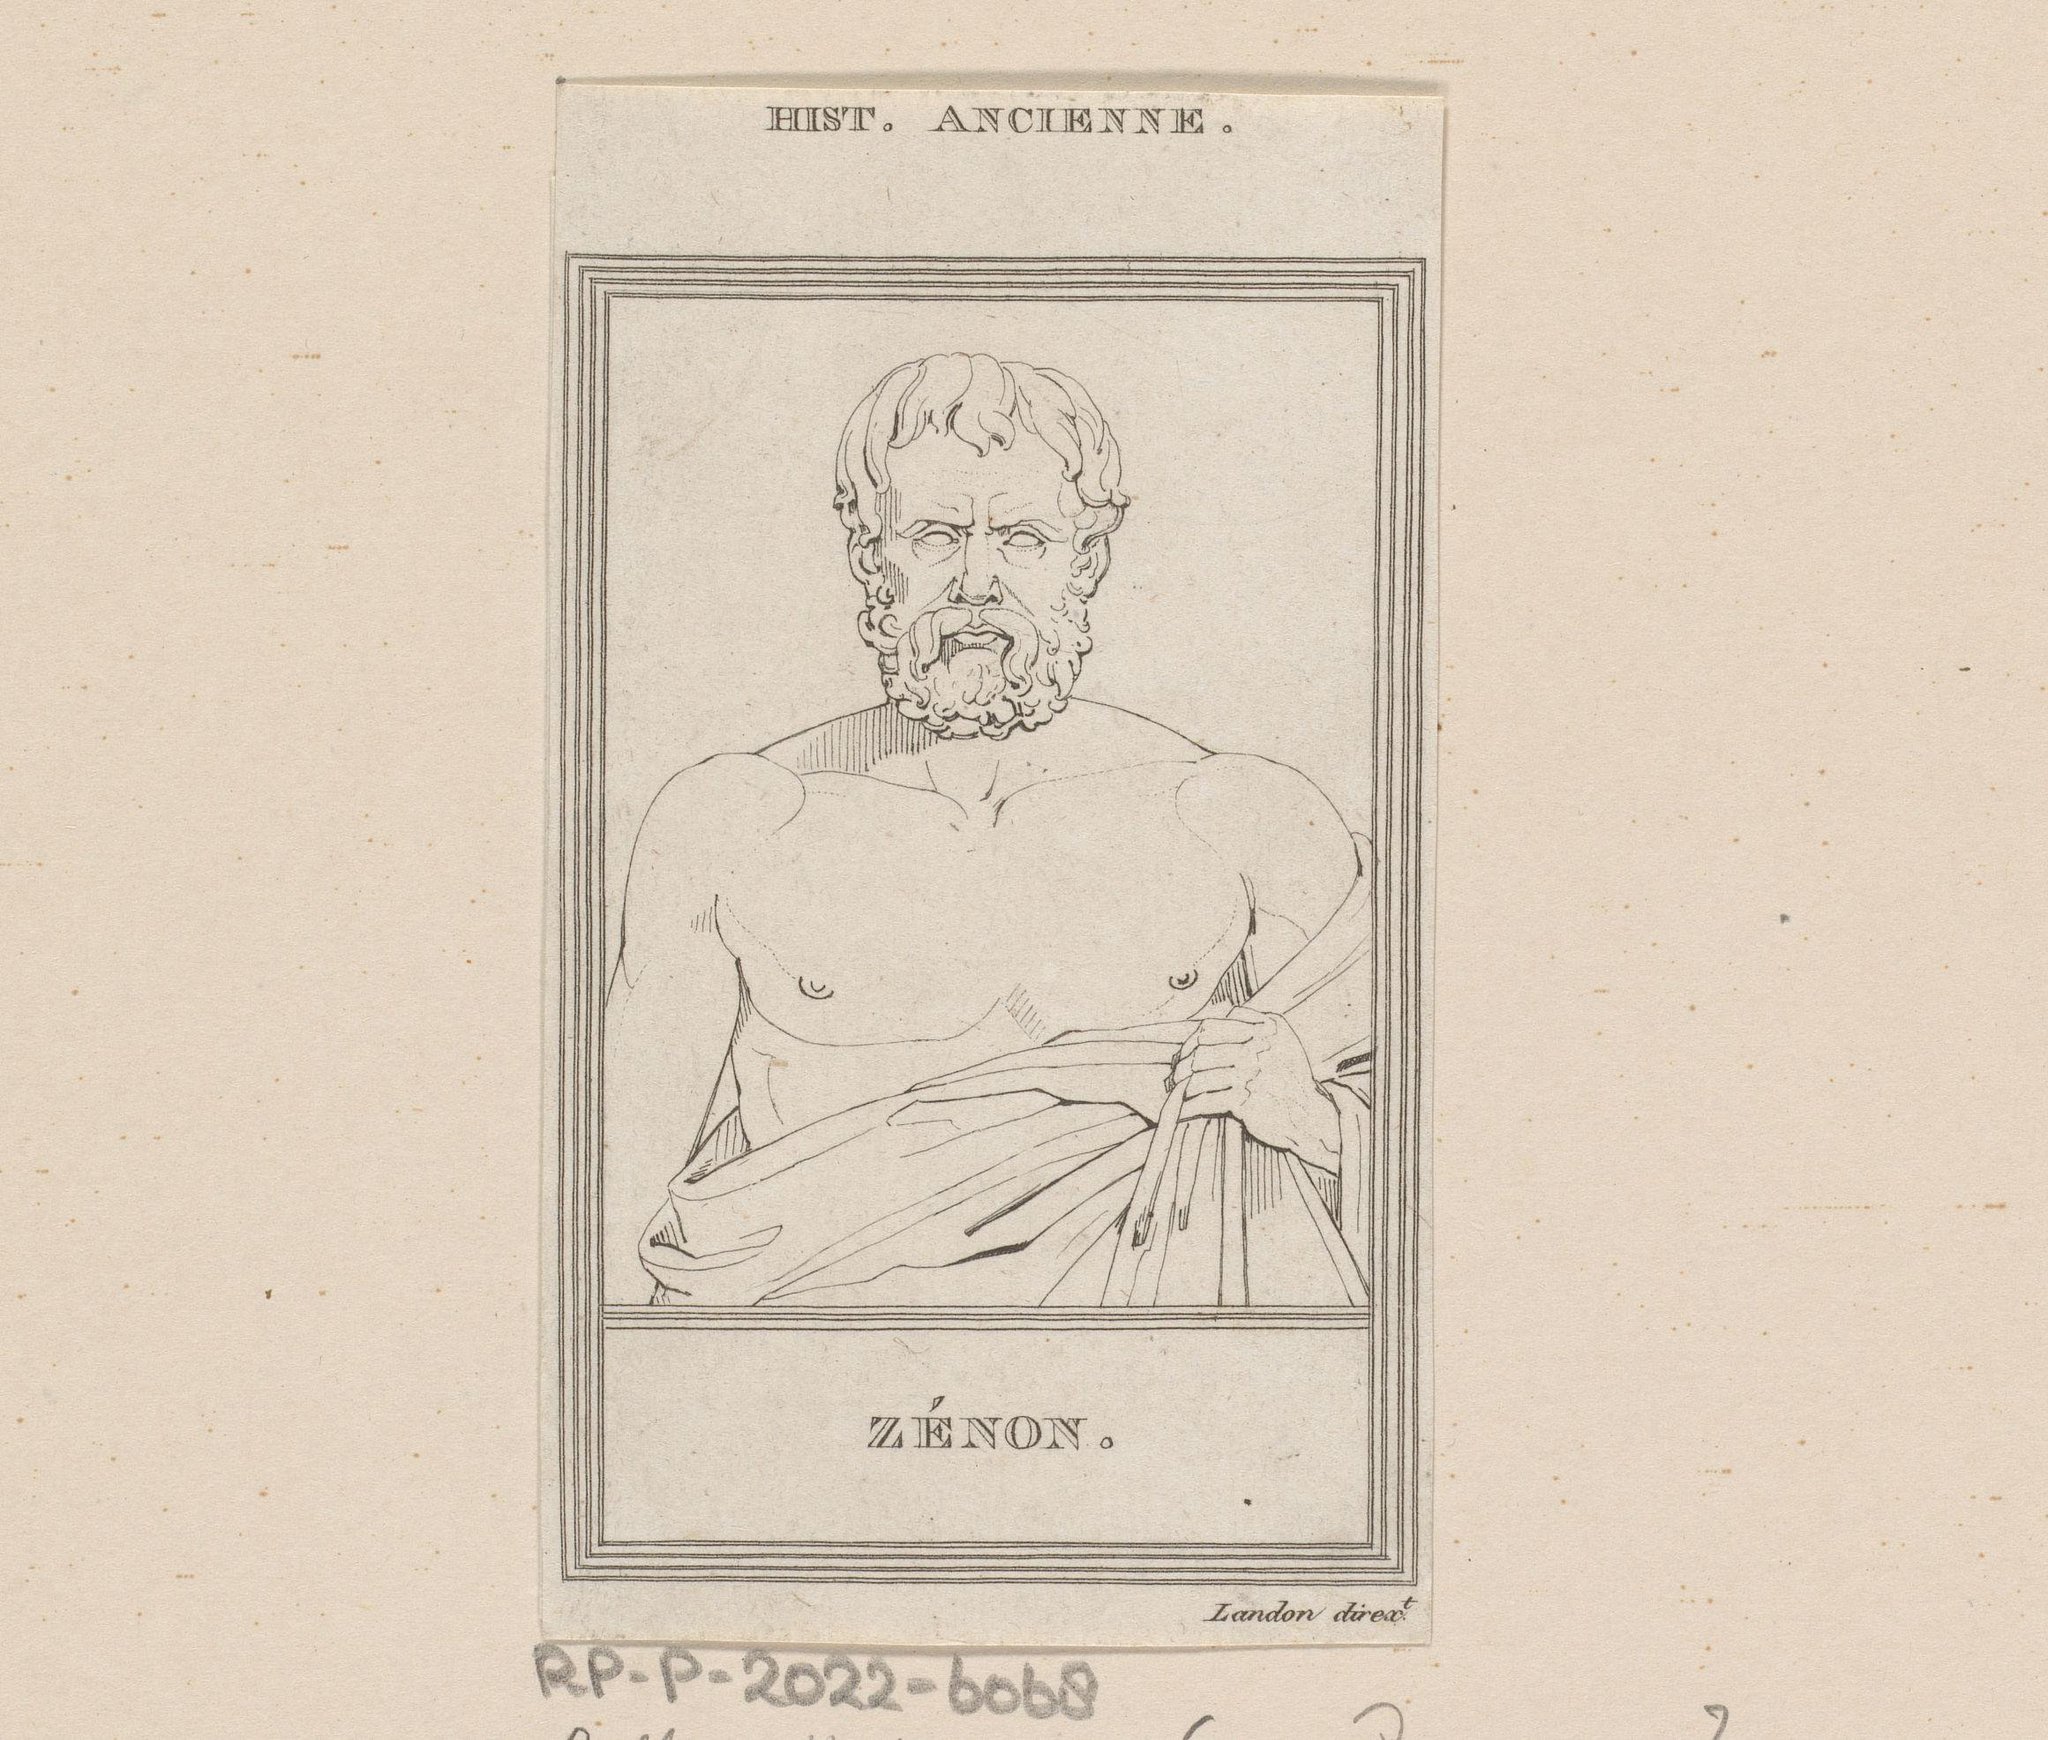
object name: book illustration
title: Portret van Zeno van Citium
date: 1805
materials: paper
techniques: etching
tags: scholar, philosopher, historical persons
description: Prent waarschijnlijk uit: Galerie historique des hommes les plus célèbres (...). Parijs: Charles Paul Landon, 1805, dl. 4.